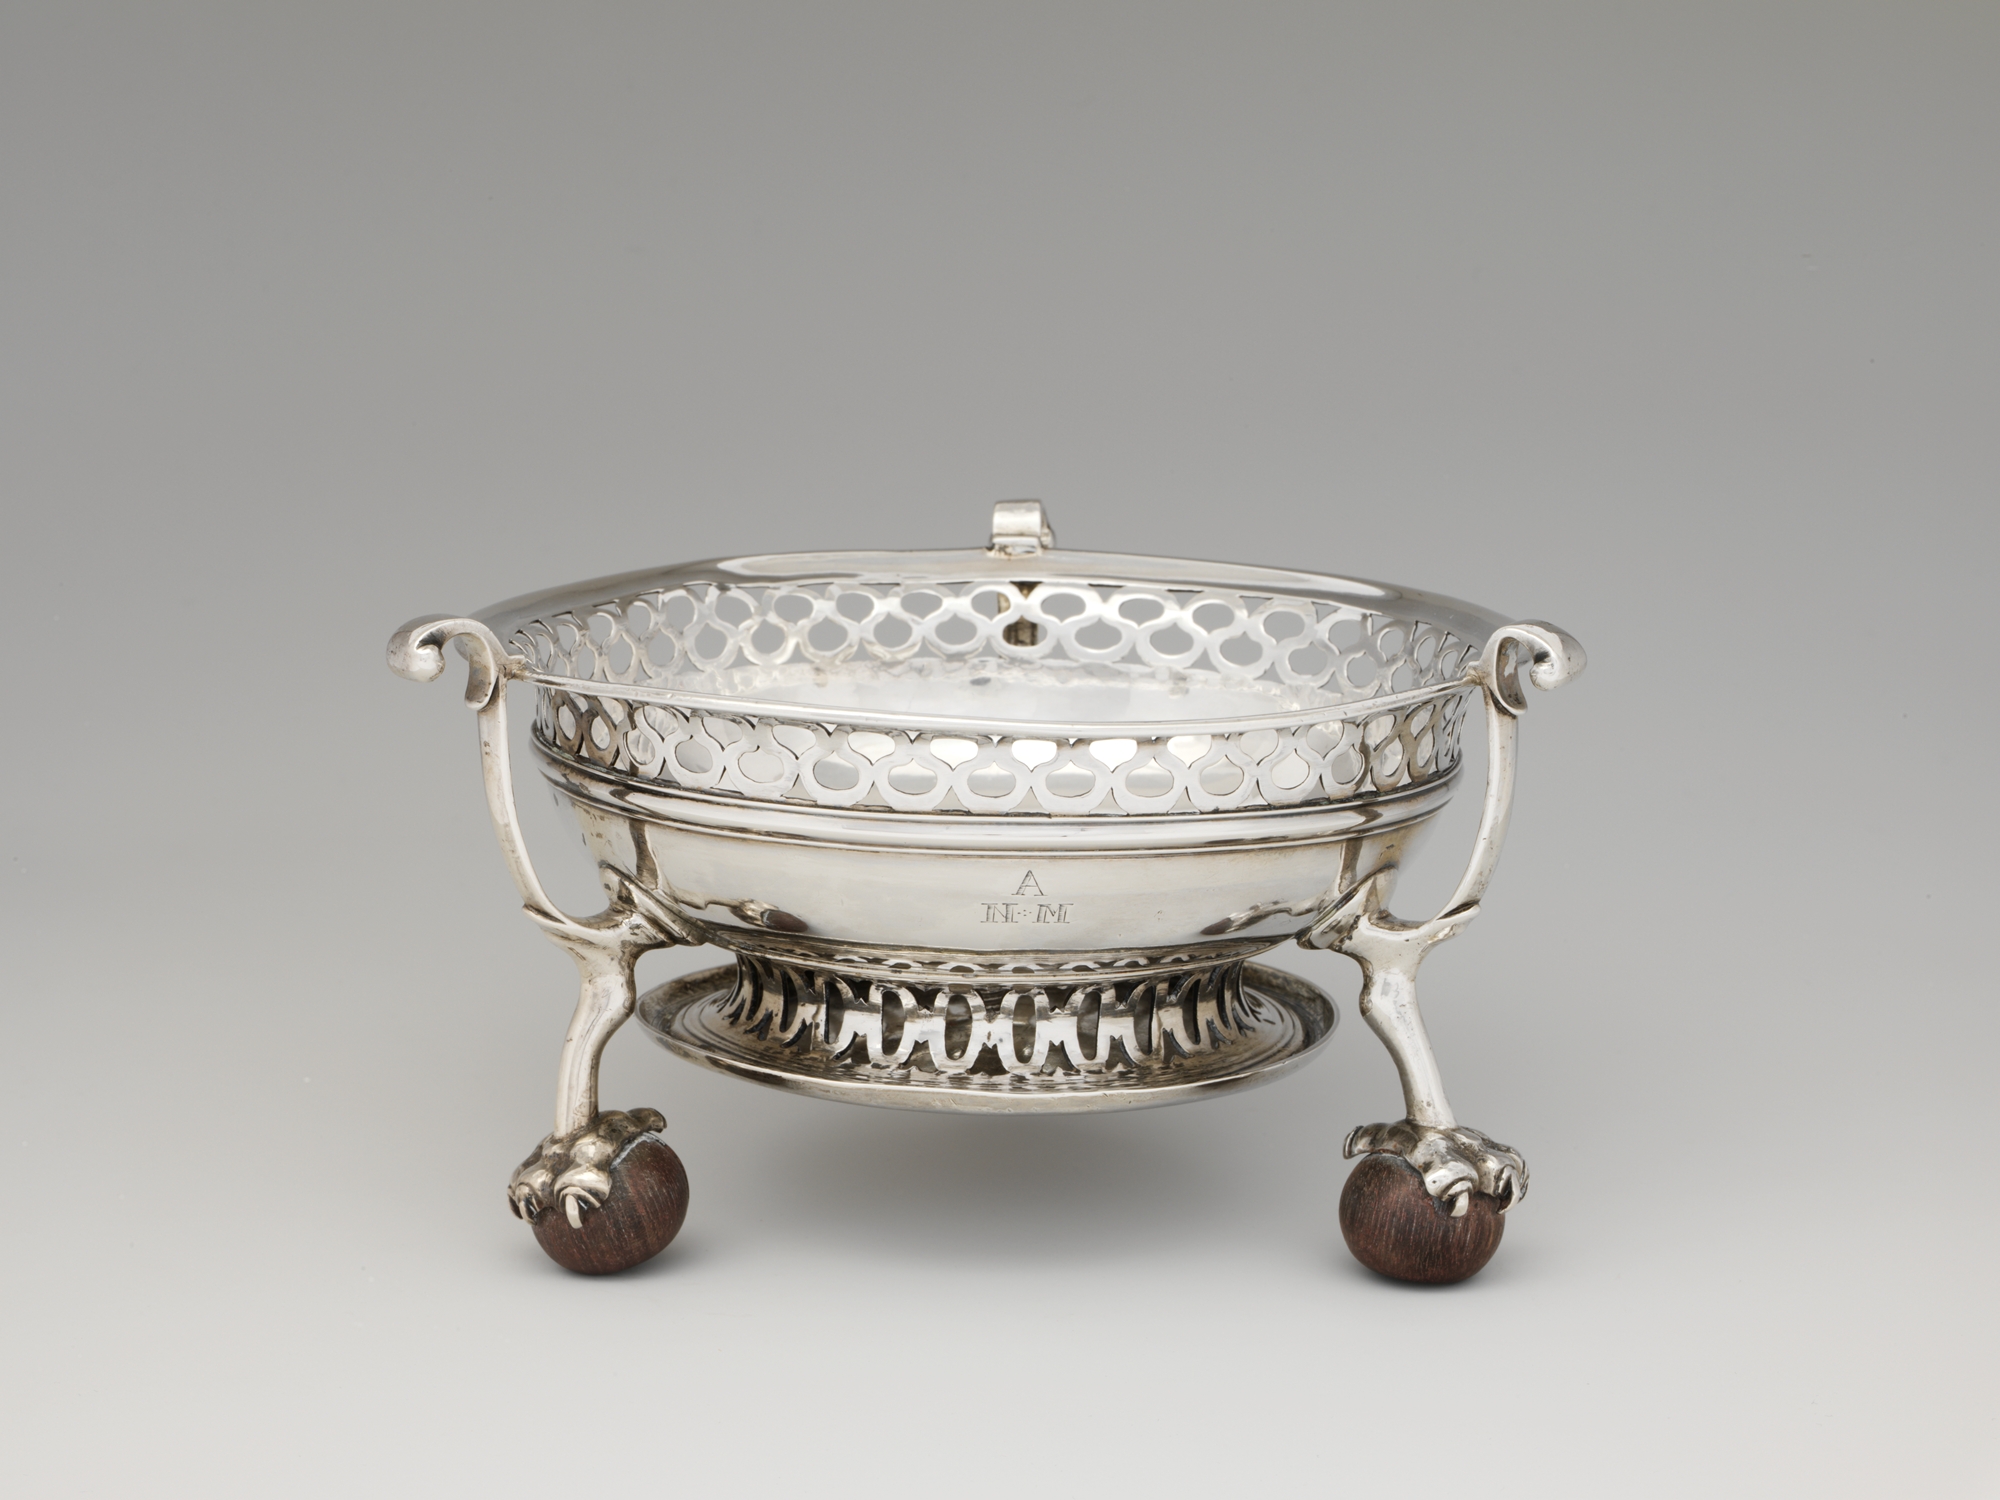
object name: chafing dish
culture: american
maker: john coney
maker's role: maker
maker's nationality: american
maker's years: 1655-1722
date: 1719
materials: silver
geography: united states